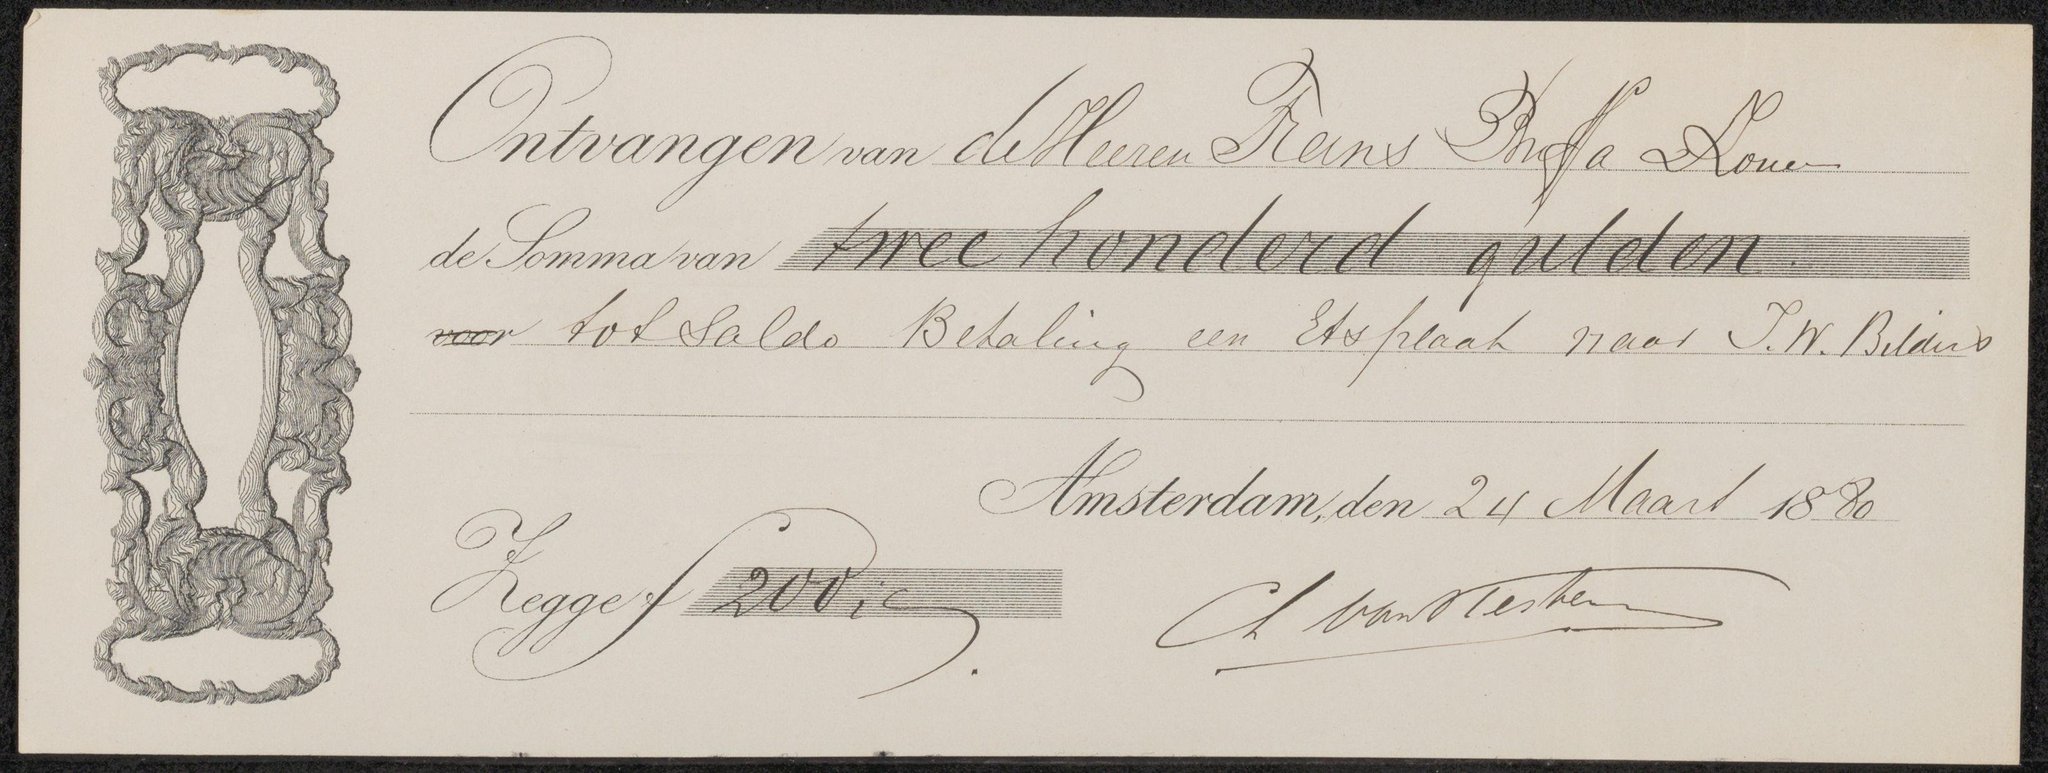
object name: ontvangstbewijs, kwitantie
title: Kwitantie voor Christiaan Lodewijk van Kesteren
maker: christiaan lodewijk van kesteren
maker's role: print maker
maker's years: 1832-1897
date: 1880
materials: ink, paper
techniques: pen, printing, writing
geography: amsterdam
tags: utrecht, painter, print maker, johannes warnardus bilders, the graphic arts, money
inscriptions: collector's mark: Lugt 2233